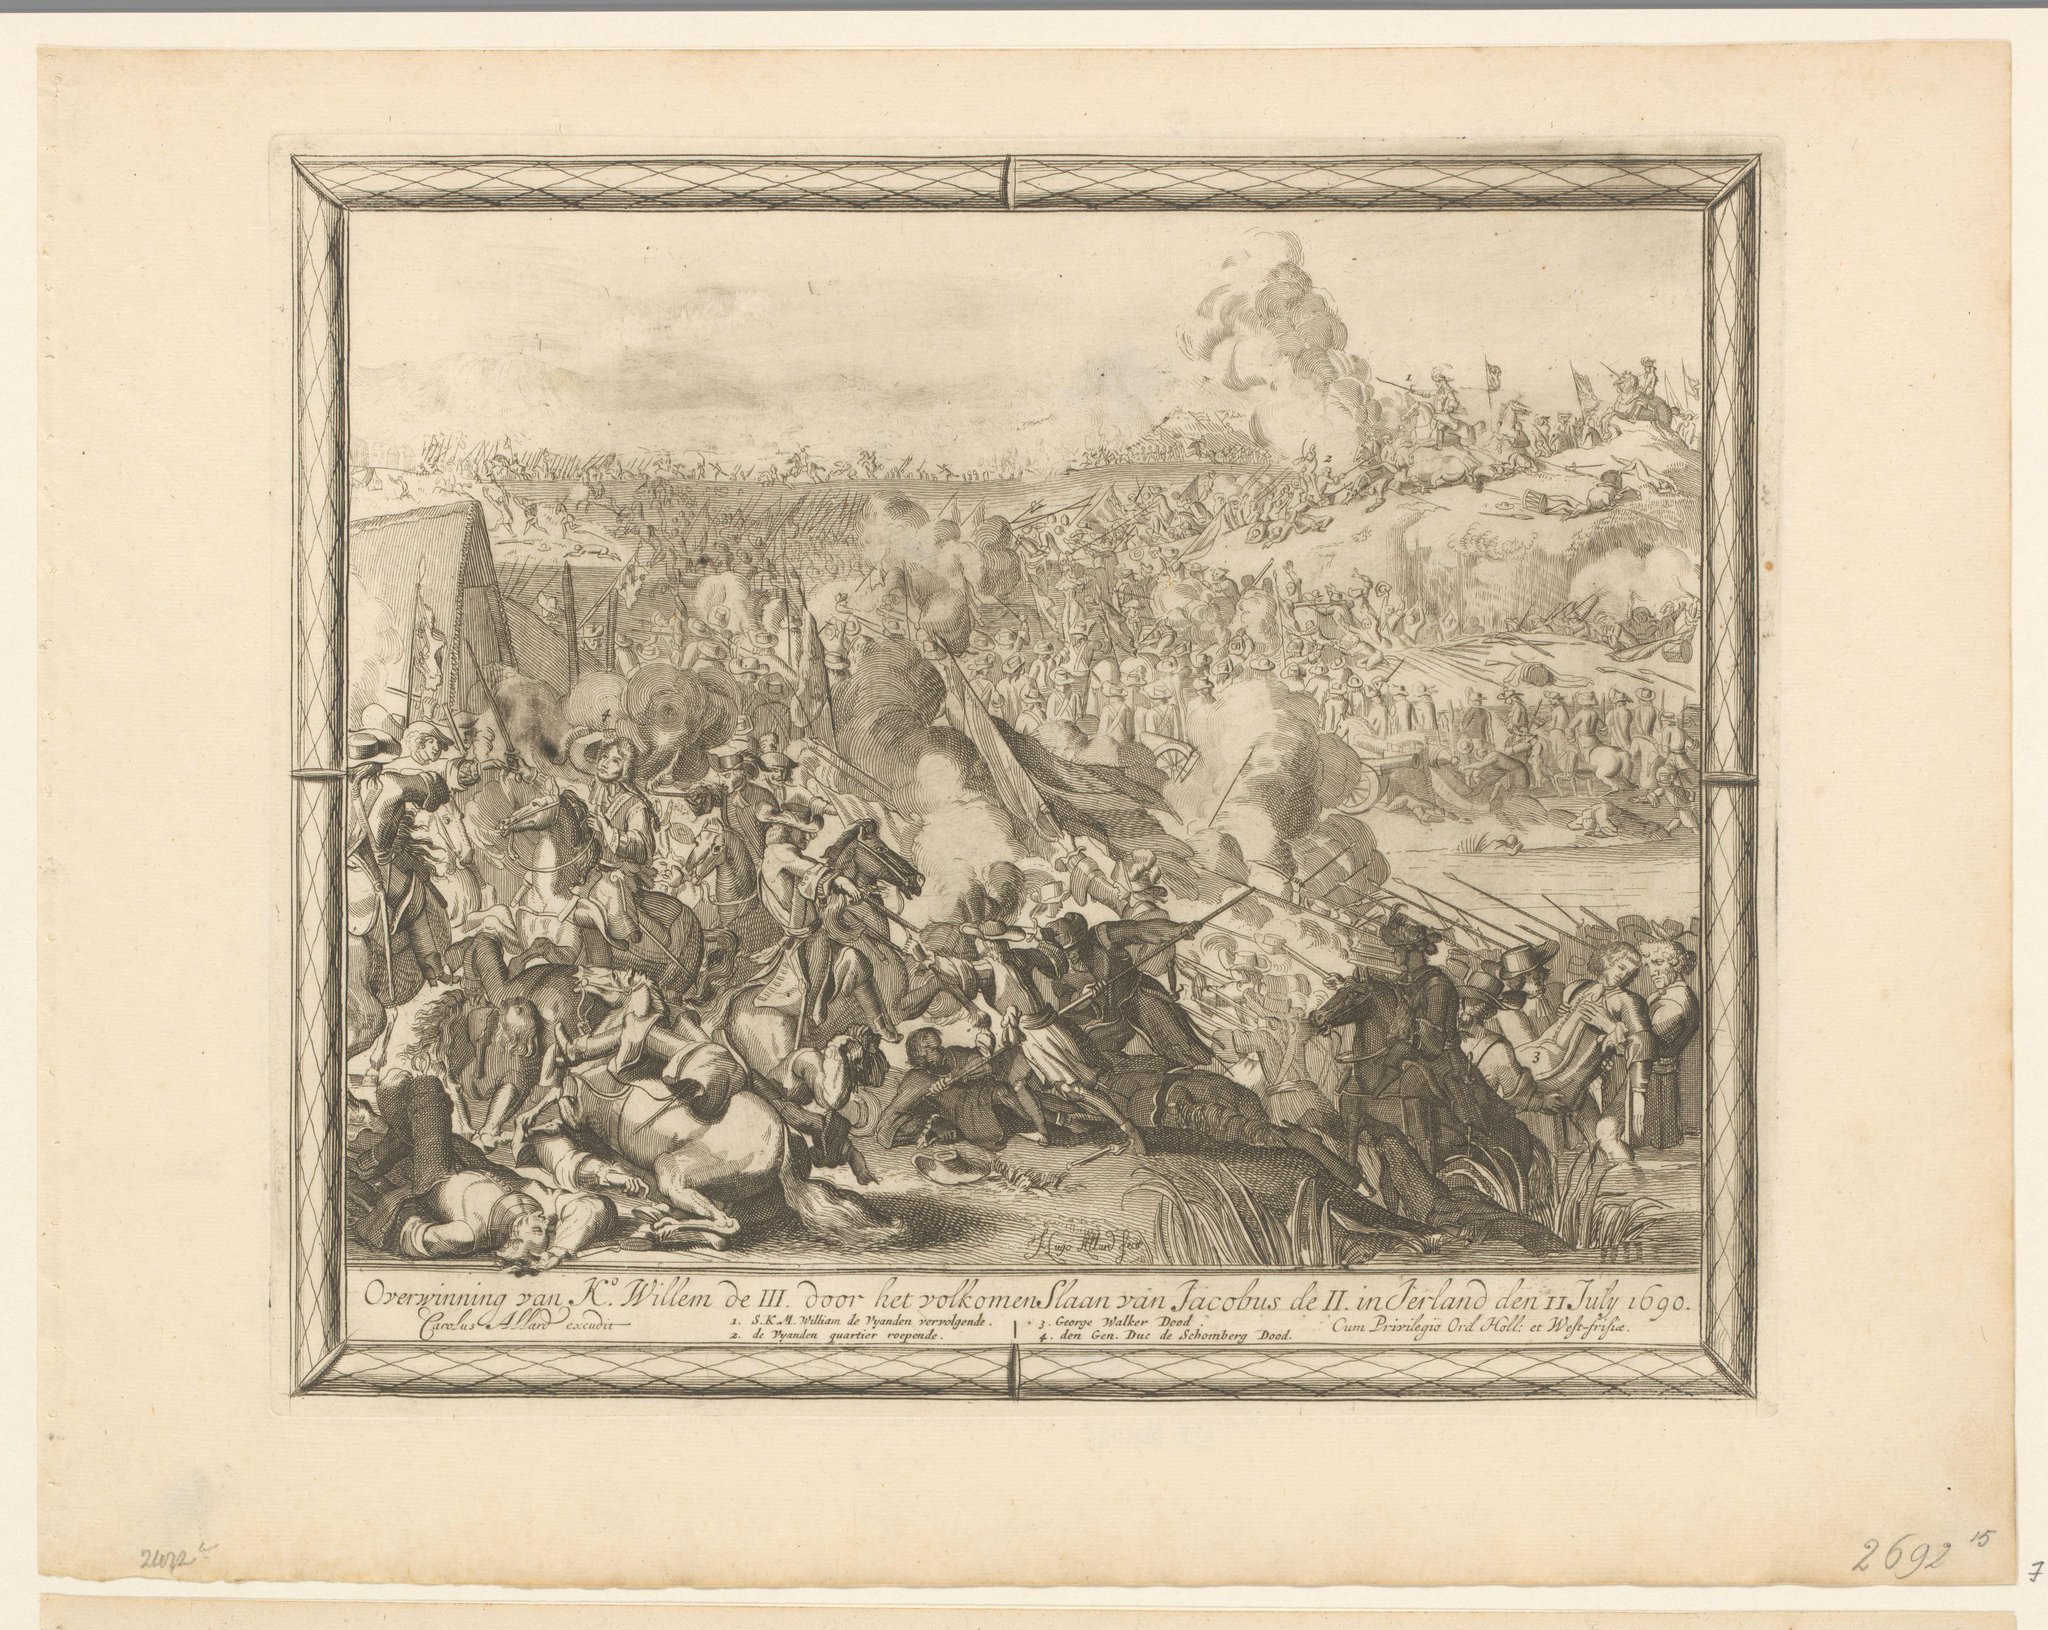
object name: print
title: Overwinning van Ko. Willem de III. door het volkomen Slaan van Jacobus de II. in Ierland den 11 July 1690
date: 1691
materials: paper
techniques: engraving, etching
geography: northern netherlands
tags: jacobus ii (koning van engeland en schotland), the hague, william iii (prince of orange and king of england, scotland, and ireland), battle (+ land forces)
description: Het Engelse leger onder Willem III verslaat de katholieken van de afgezette koning Jacobus II in Ierland bij de Boyne, 11 juli 1690. In het onderschrift de legenda 1-4. Plaat 15 in een serie van 20 platen over de Glorious Revolution in Engeland in de jaren 1688-1691.